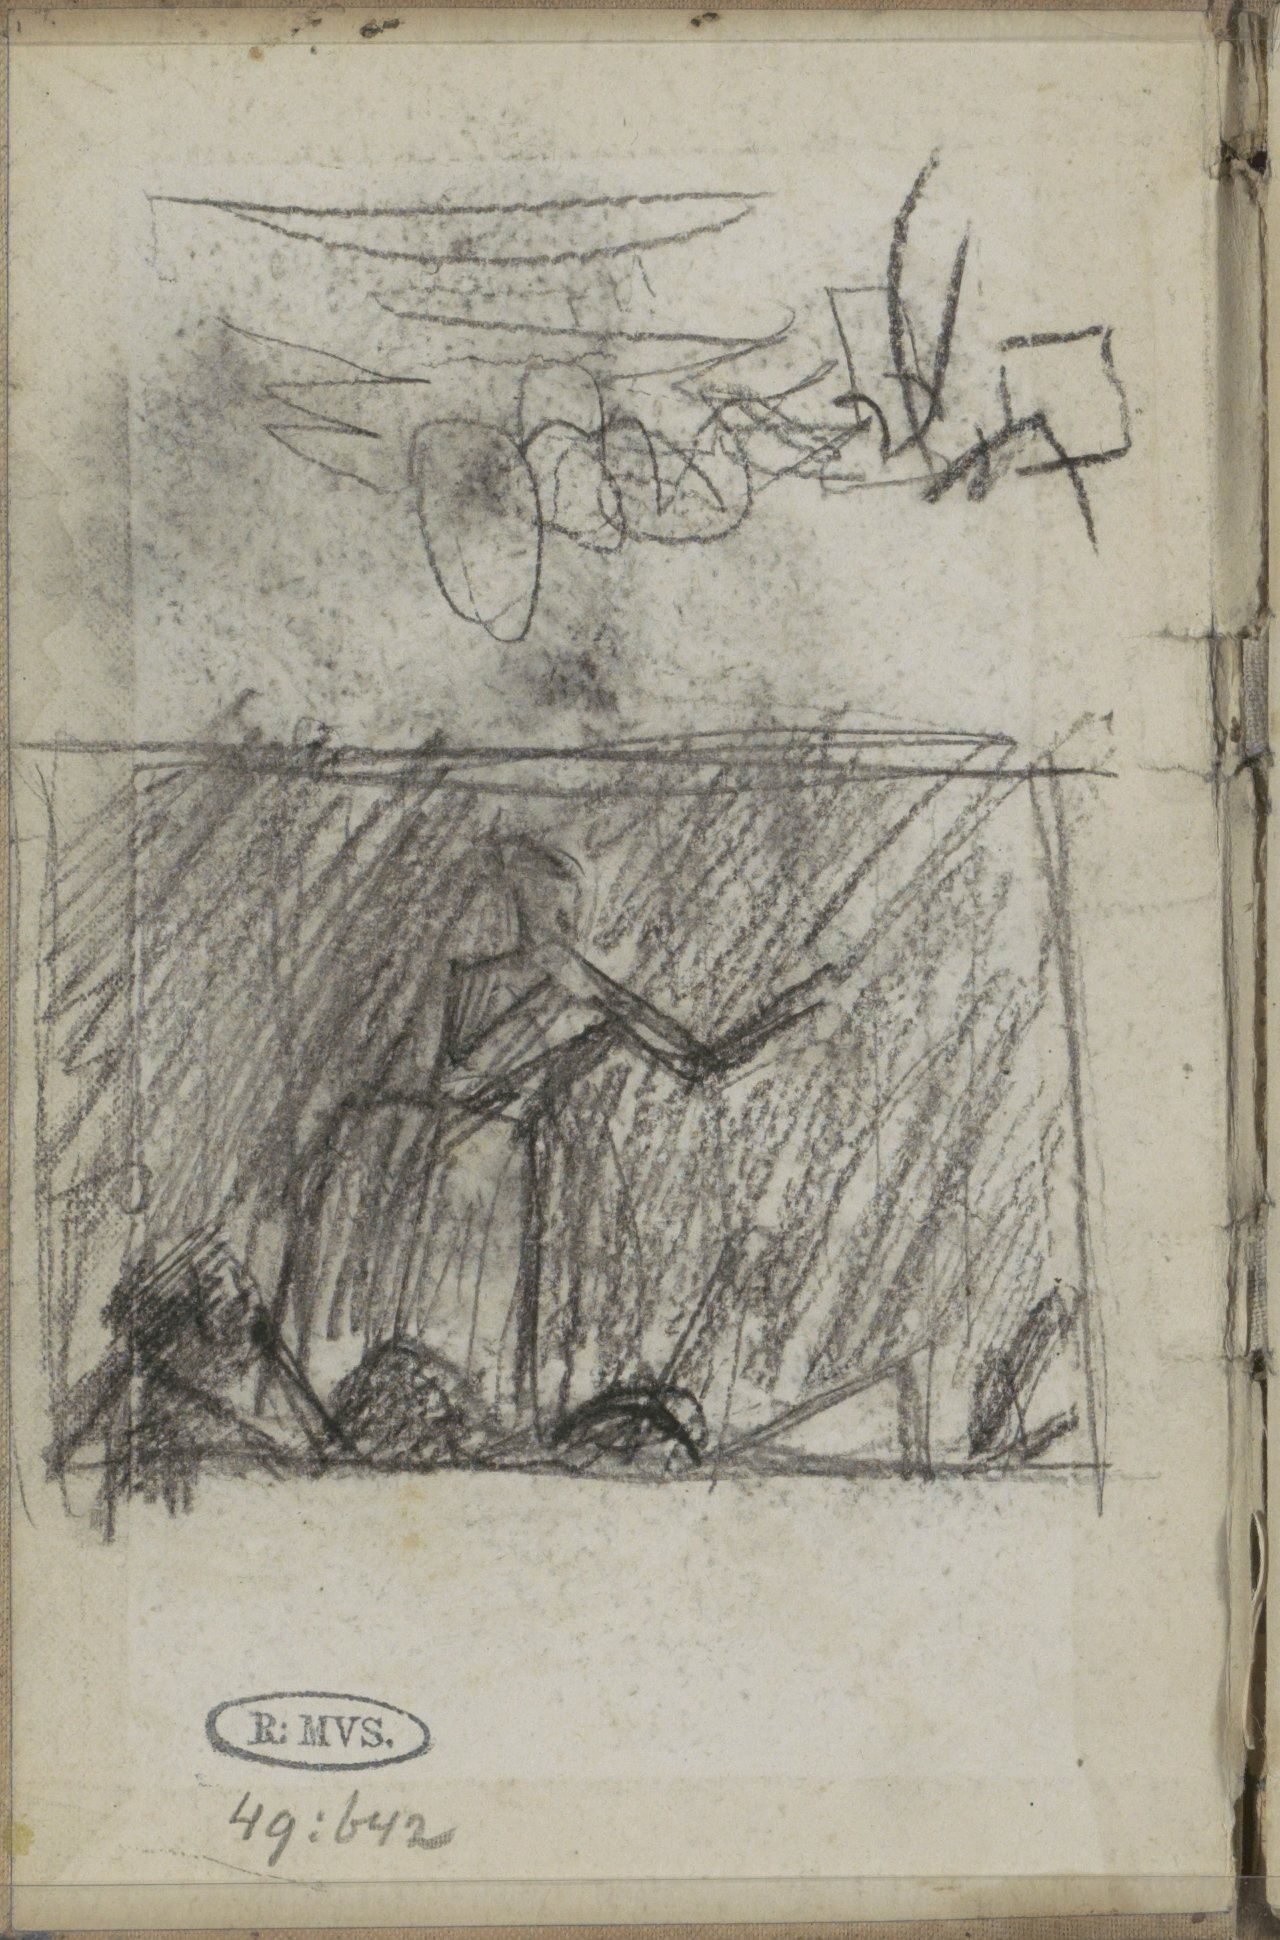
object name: endleaf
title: Studieblad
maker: marius bauer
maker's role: draughtsman, print maker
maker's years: 1867-1932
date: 1888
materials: chalk, paper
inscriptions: collector's mark: Lugt 2228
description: Pagina 1, schutblad, uit een schetsboek met 58 bladen.